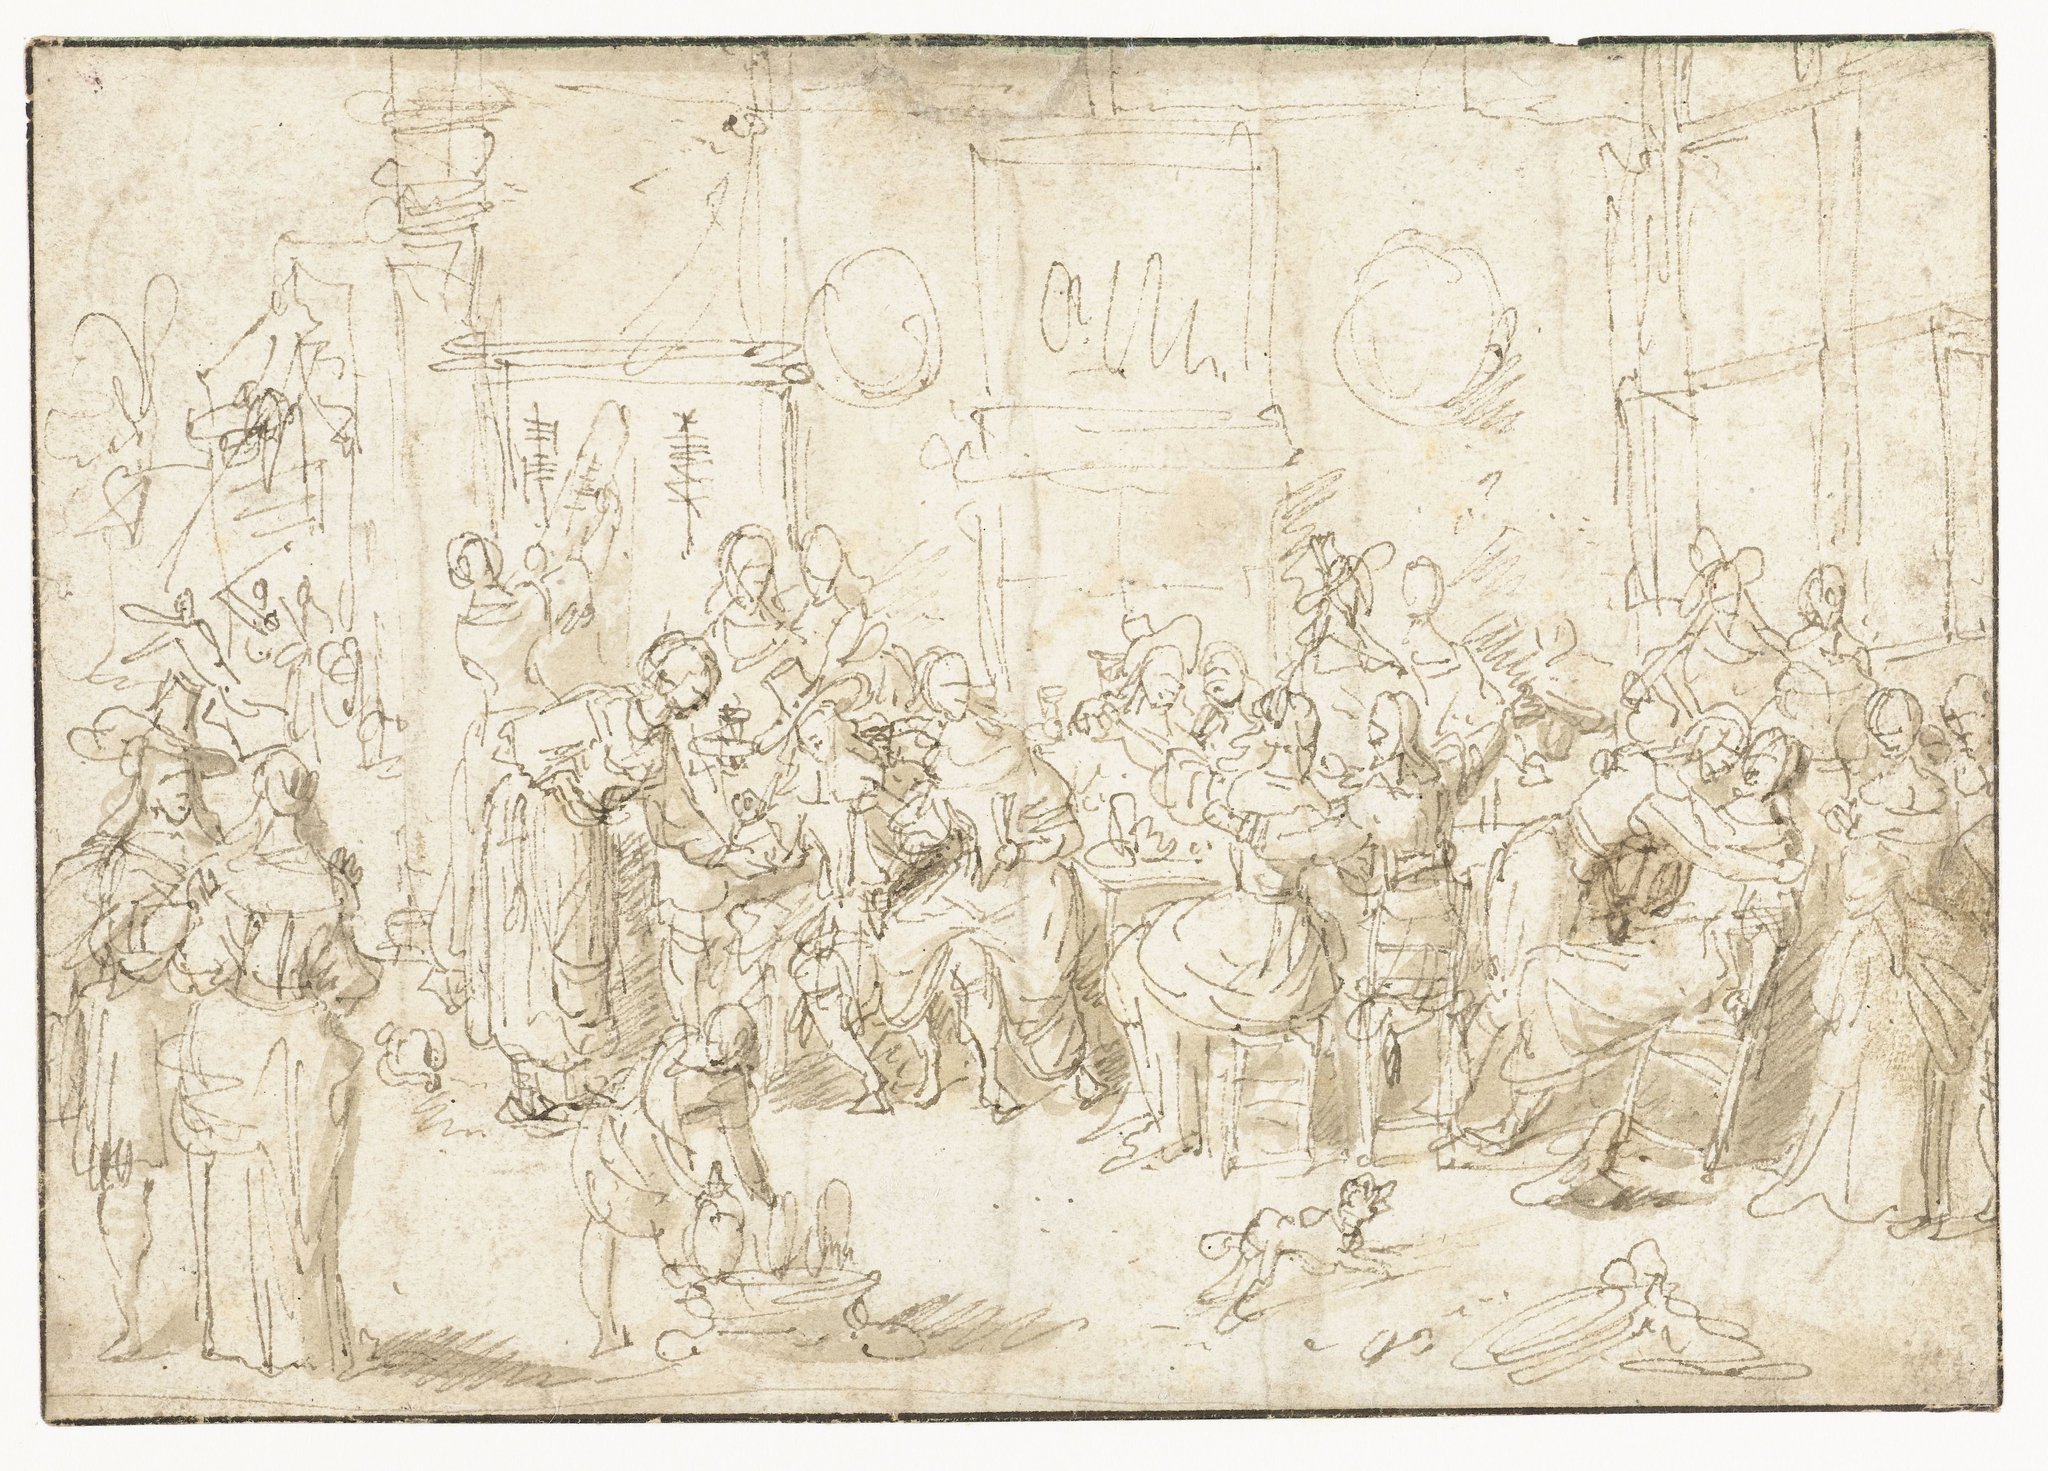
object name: drawing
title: Interieur met vrolijk gezelschap rond een tafel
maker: willem van herp (i)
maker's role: draughtsman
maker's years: 1614-1677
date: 1624-1677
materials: ink, paper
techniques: brush, pen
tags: celebration meal, feast, banquet, prostitution, private festivities, merry company